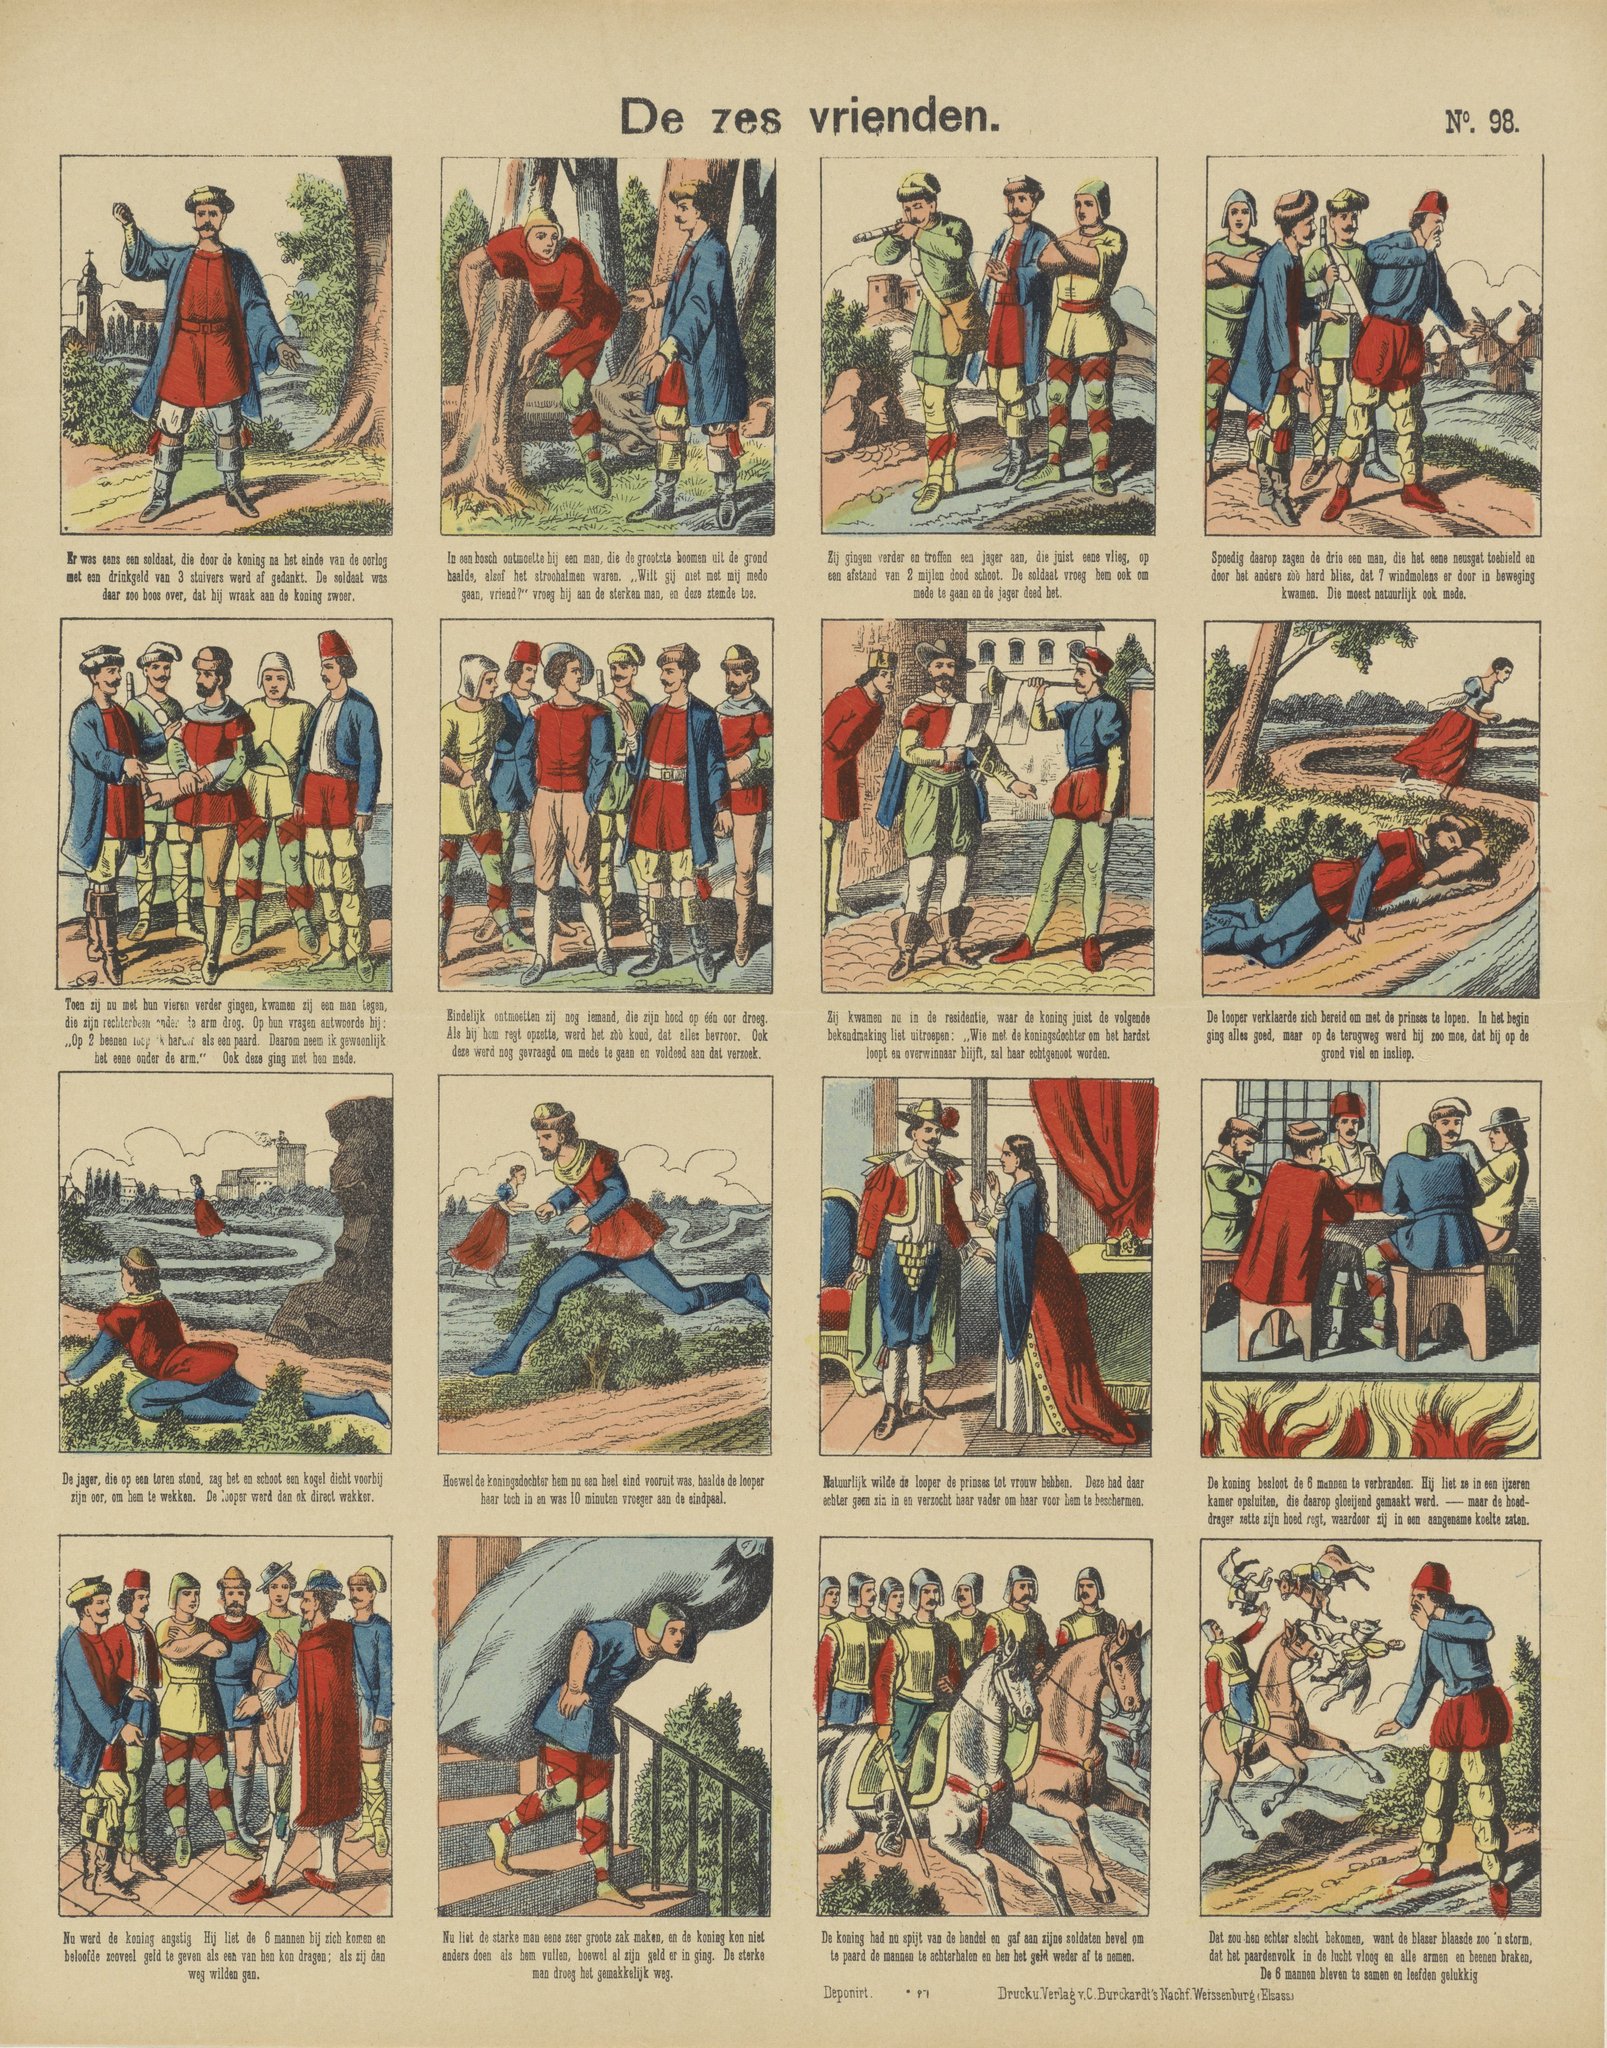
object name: print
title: De zes vrienden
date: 1889-1906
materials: paper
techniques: hand coloring, letterpress printing, lithograph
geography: wissembourg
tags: tales and fairy tales, friends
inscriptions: collector's mark: Lugt 2760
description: Blad met 16 voorstellingen uit het verhaal van de zes vrienden. Onder elke afbeelding een onderschrift. Genummerd rechtsboven: No. 98.